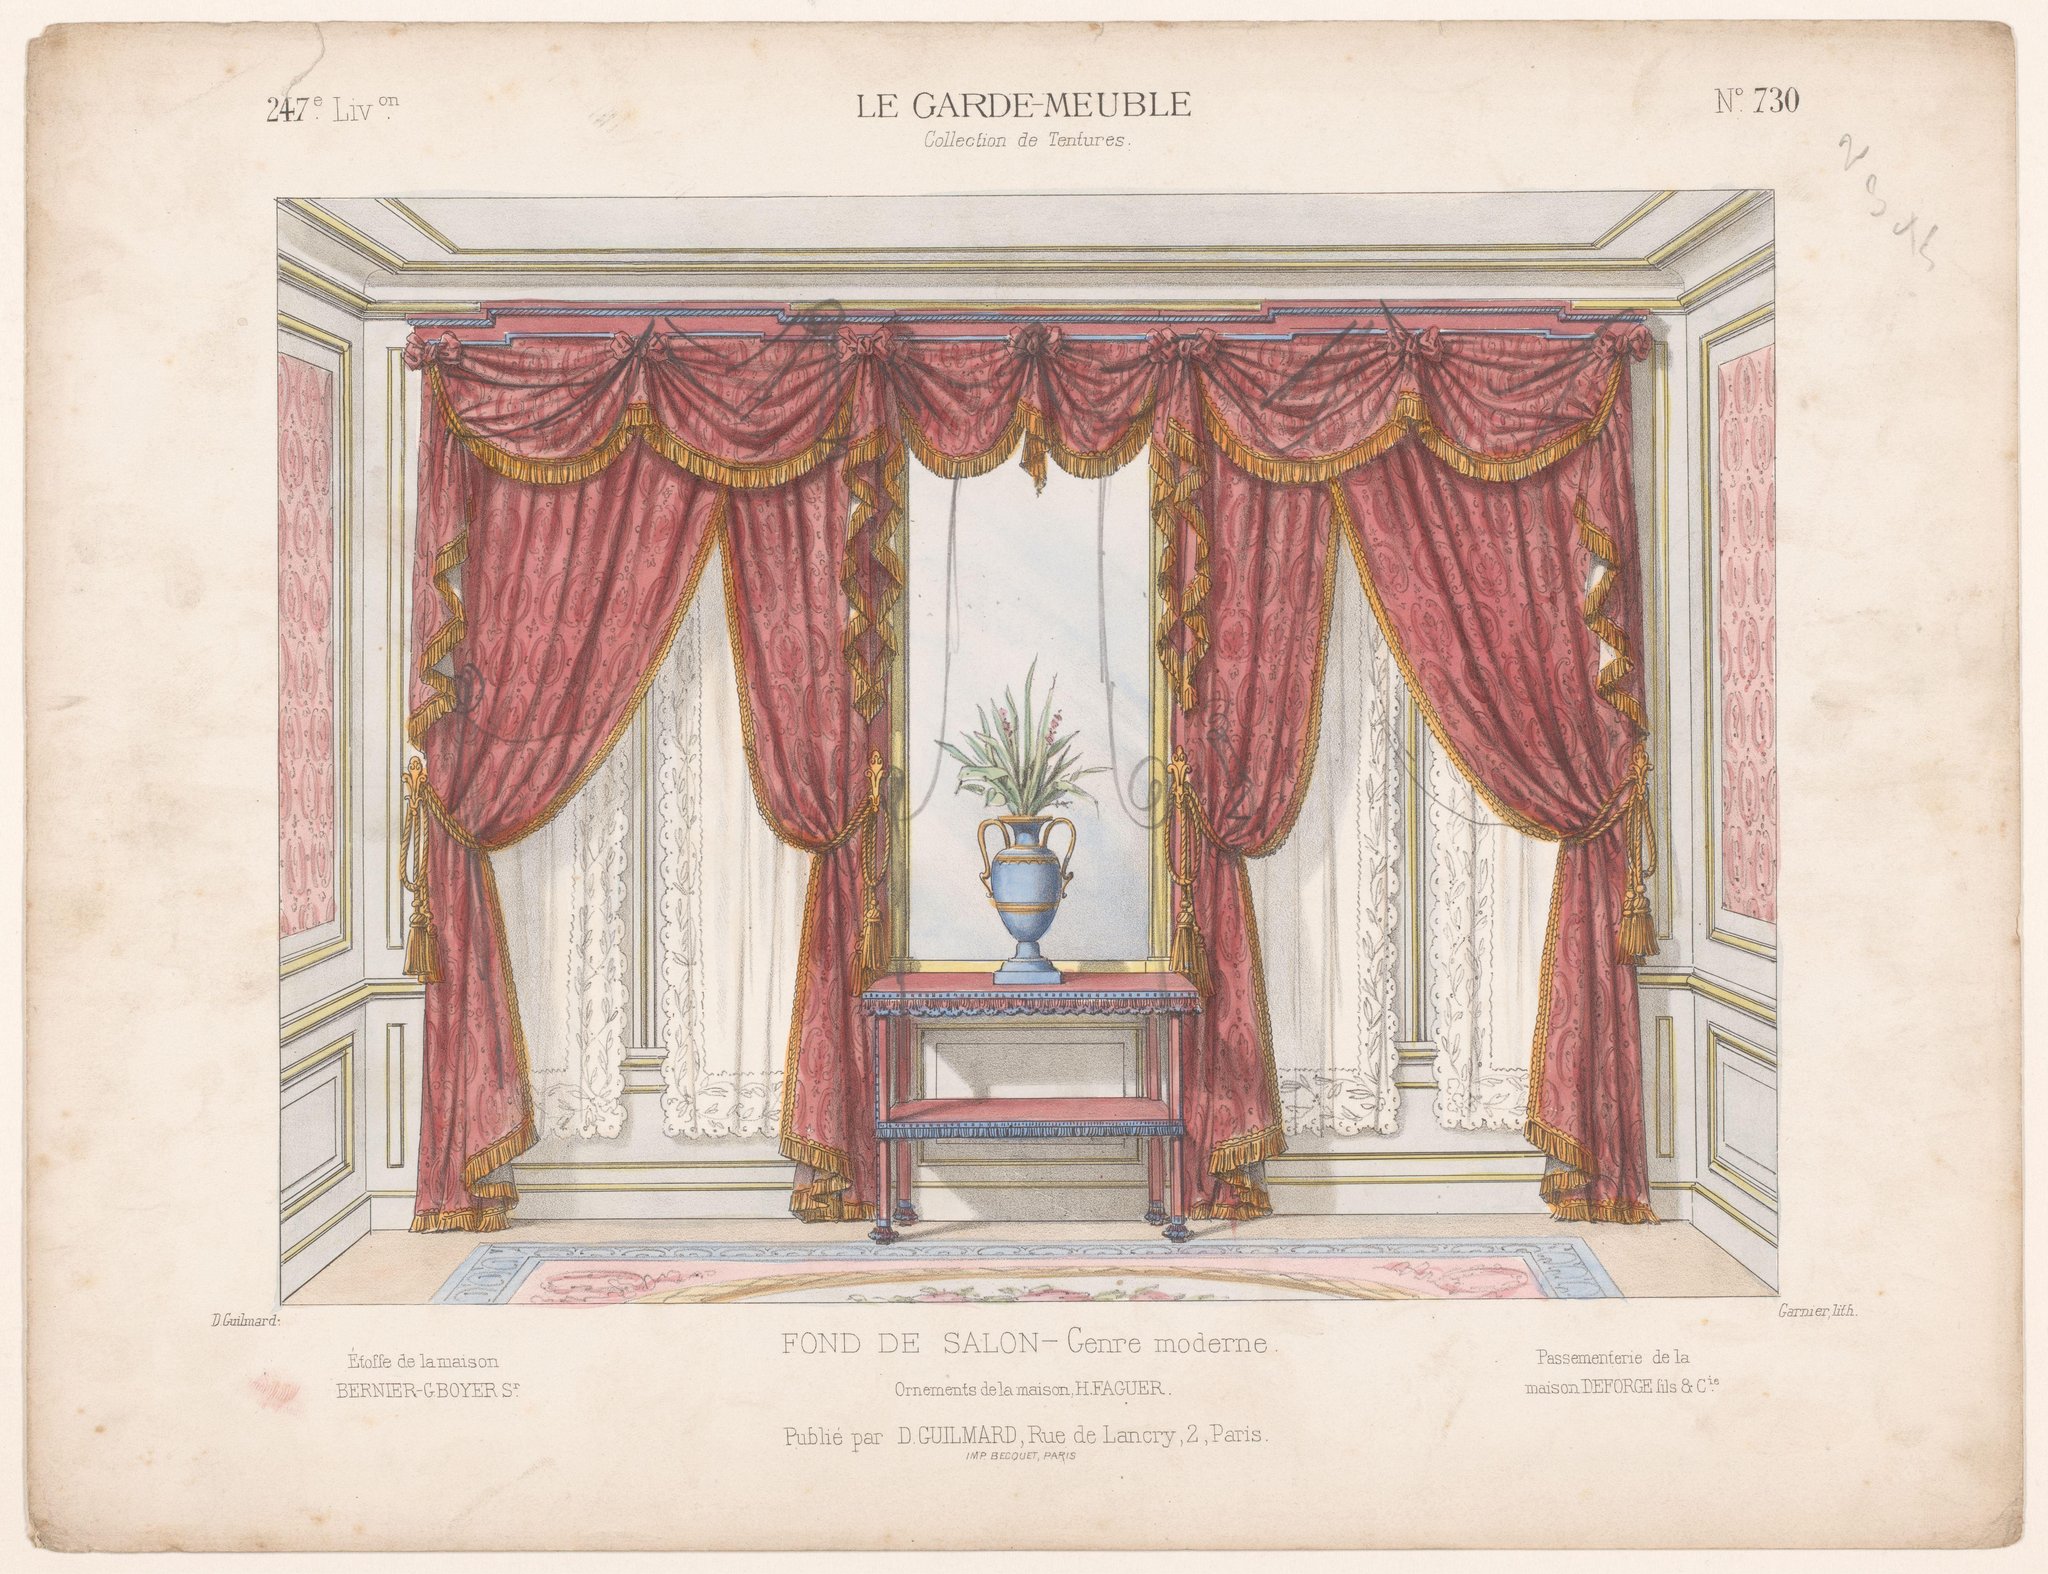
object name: print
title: Le Garde-Meuble / Collection de Tentures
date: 1860-1880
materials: paper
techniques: hand coloring, lithograph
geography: paris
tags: living-room, parlour, sitting-room, hangings and drapery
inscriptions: annotation: ‘2 3 4 5’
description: Interieur van een salon in moderne stijl. Prent uit 247e Livraison.